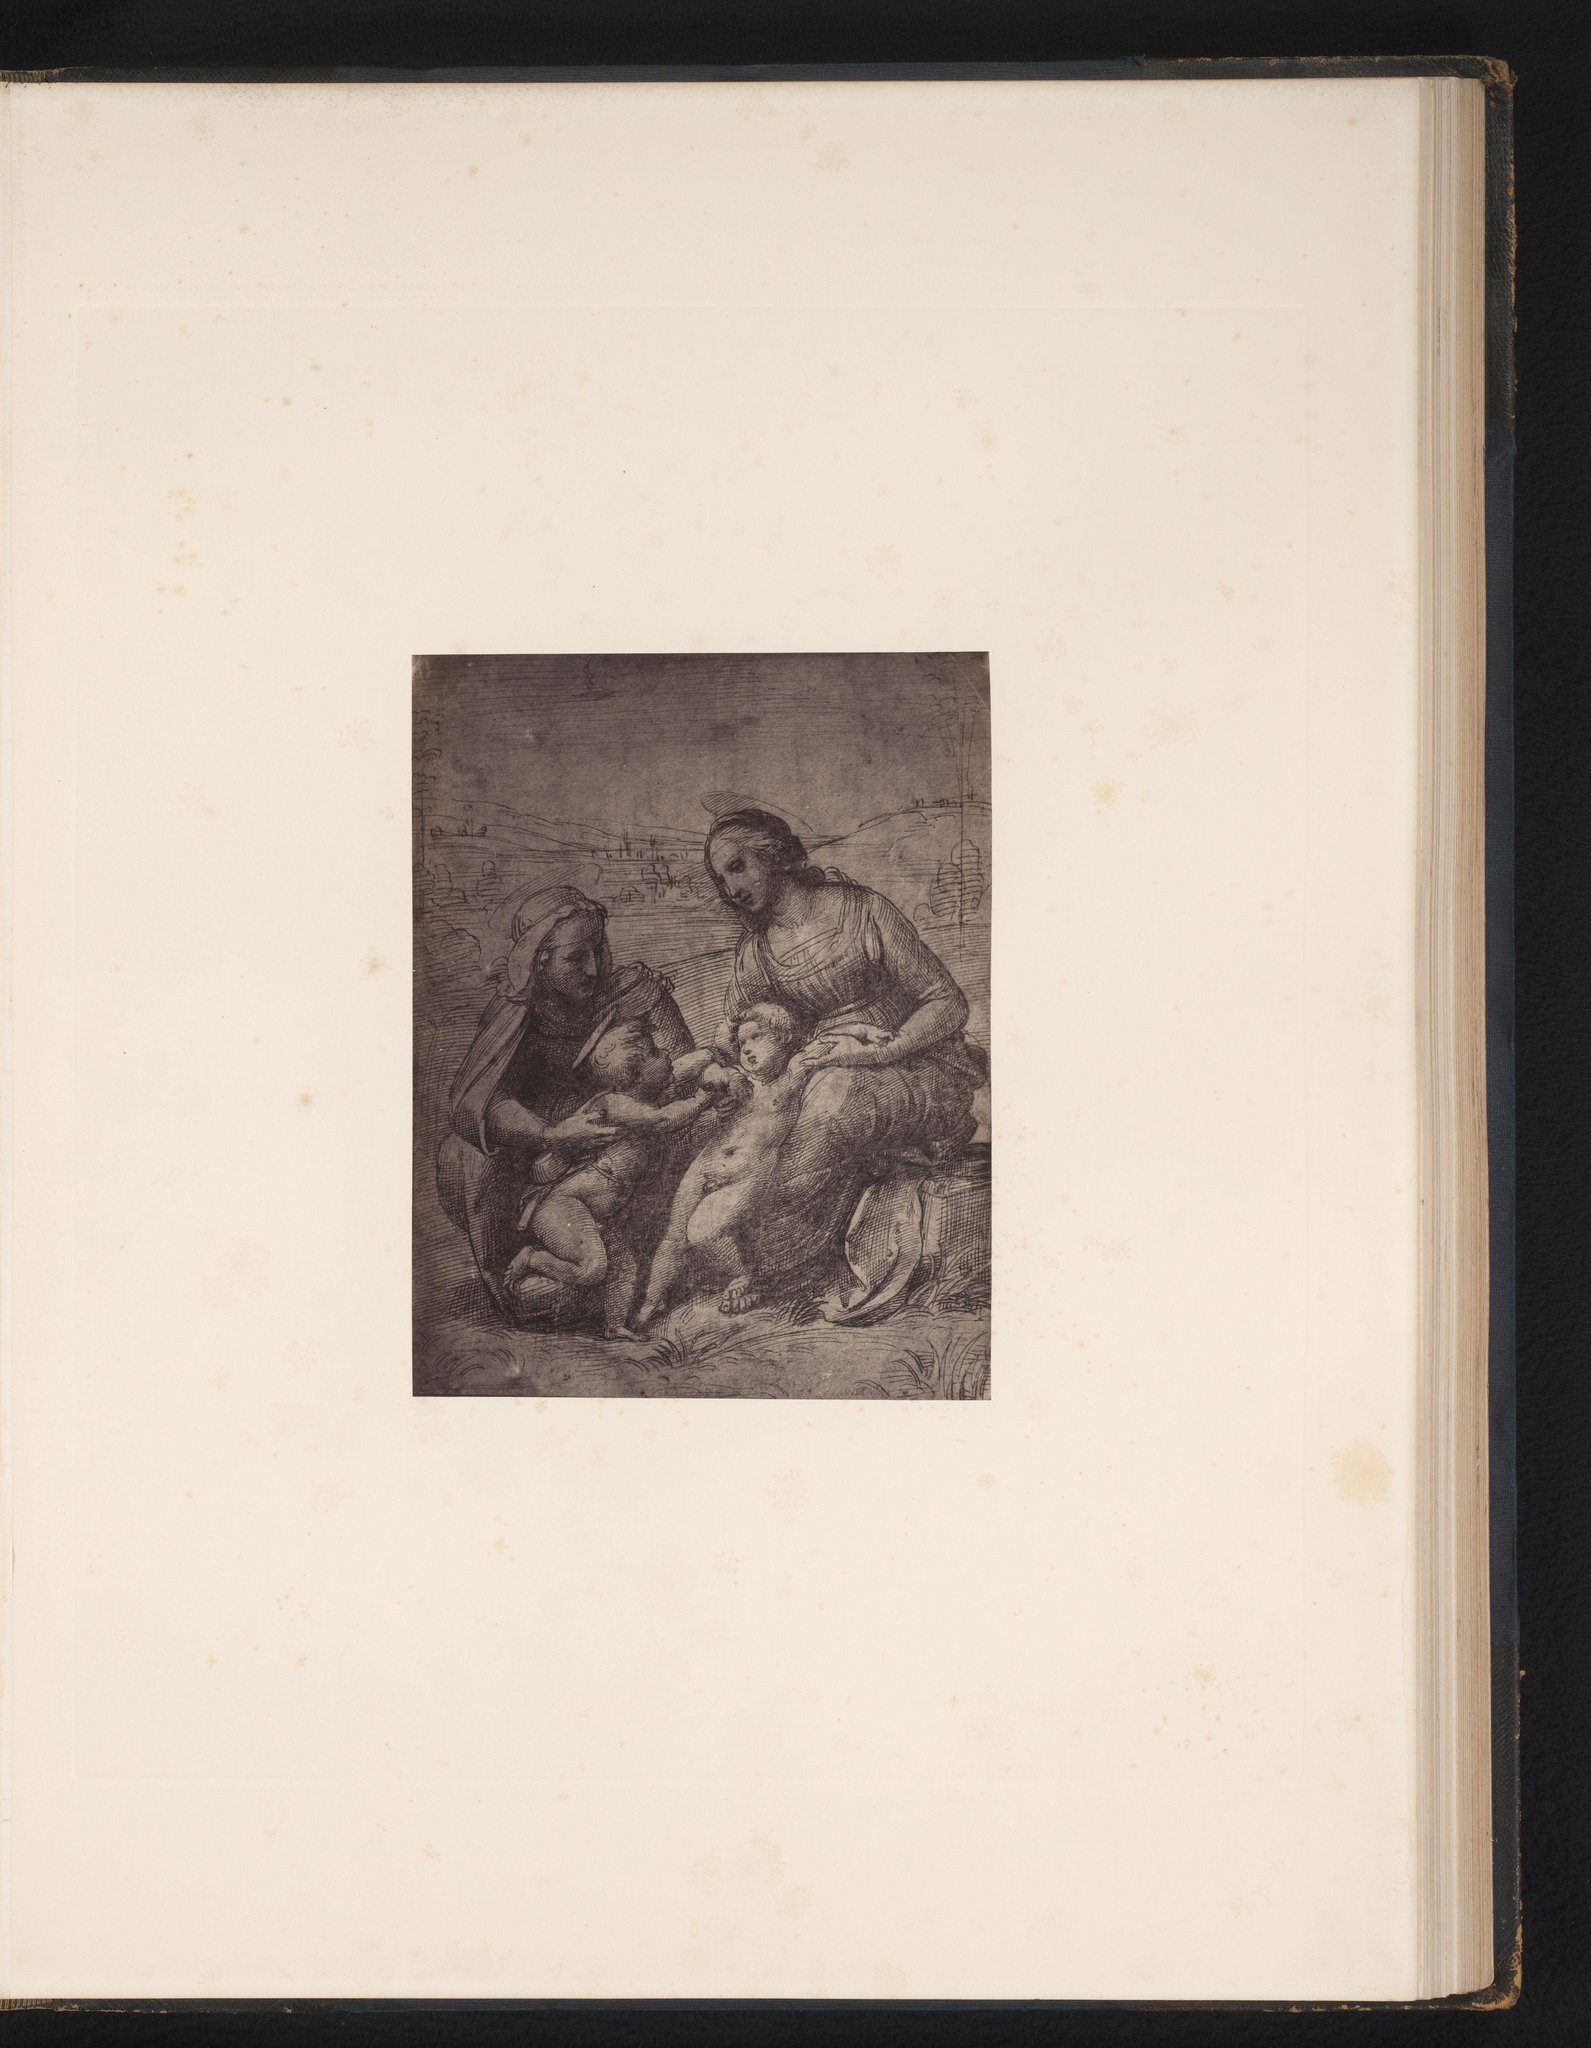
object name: reproduction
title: Fotoreproductie van een tekening van Rafaël, Maria met Christus, Johannes en Elisabet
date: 1852-1857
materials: paper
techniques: albumen print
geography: windsor castle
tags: mary, the christ-child and john the baptist, elisabeth present